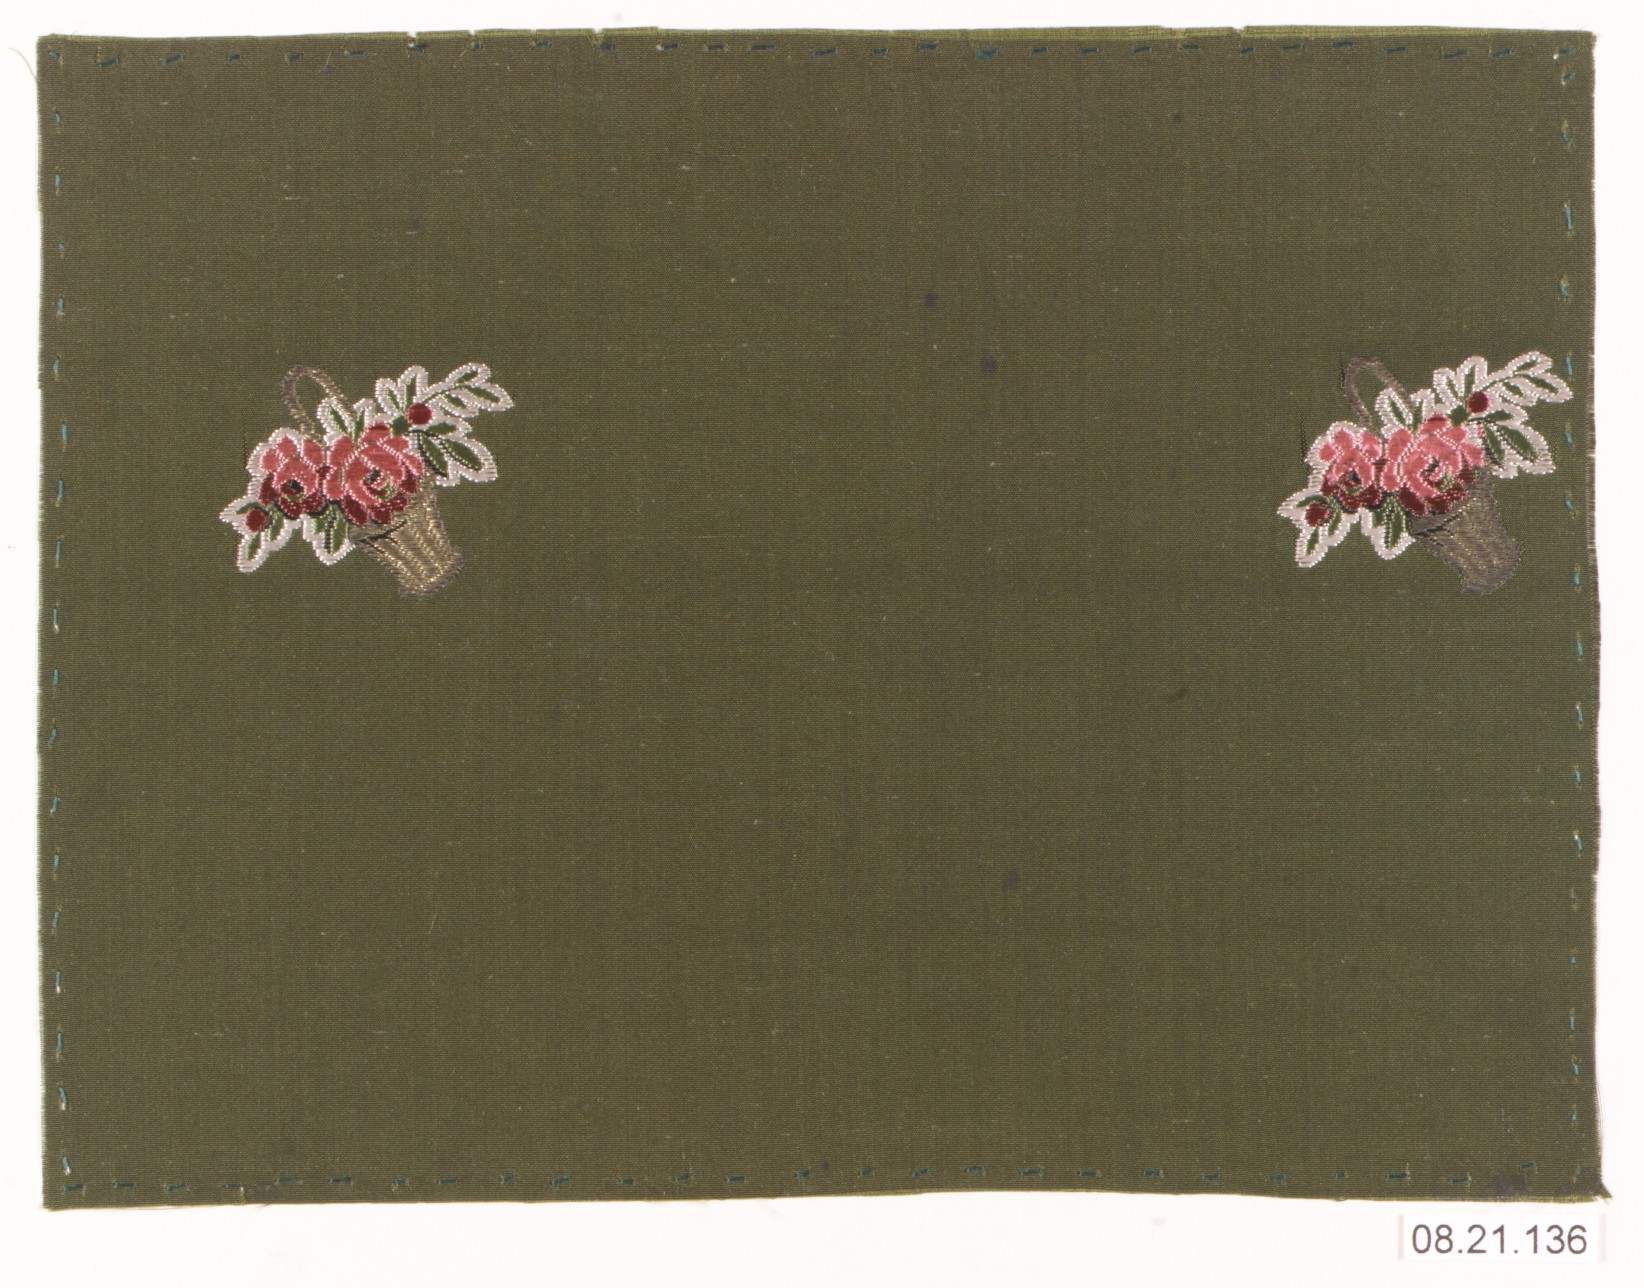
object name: textile sample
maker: Anonymous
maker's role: designer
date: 1900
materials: silk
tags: flowers